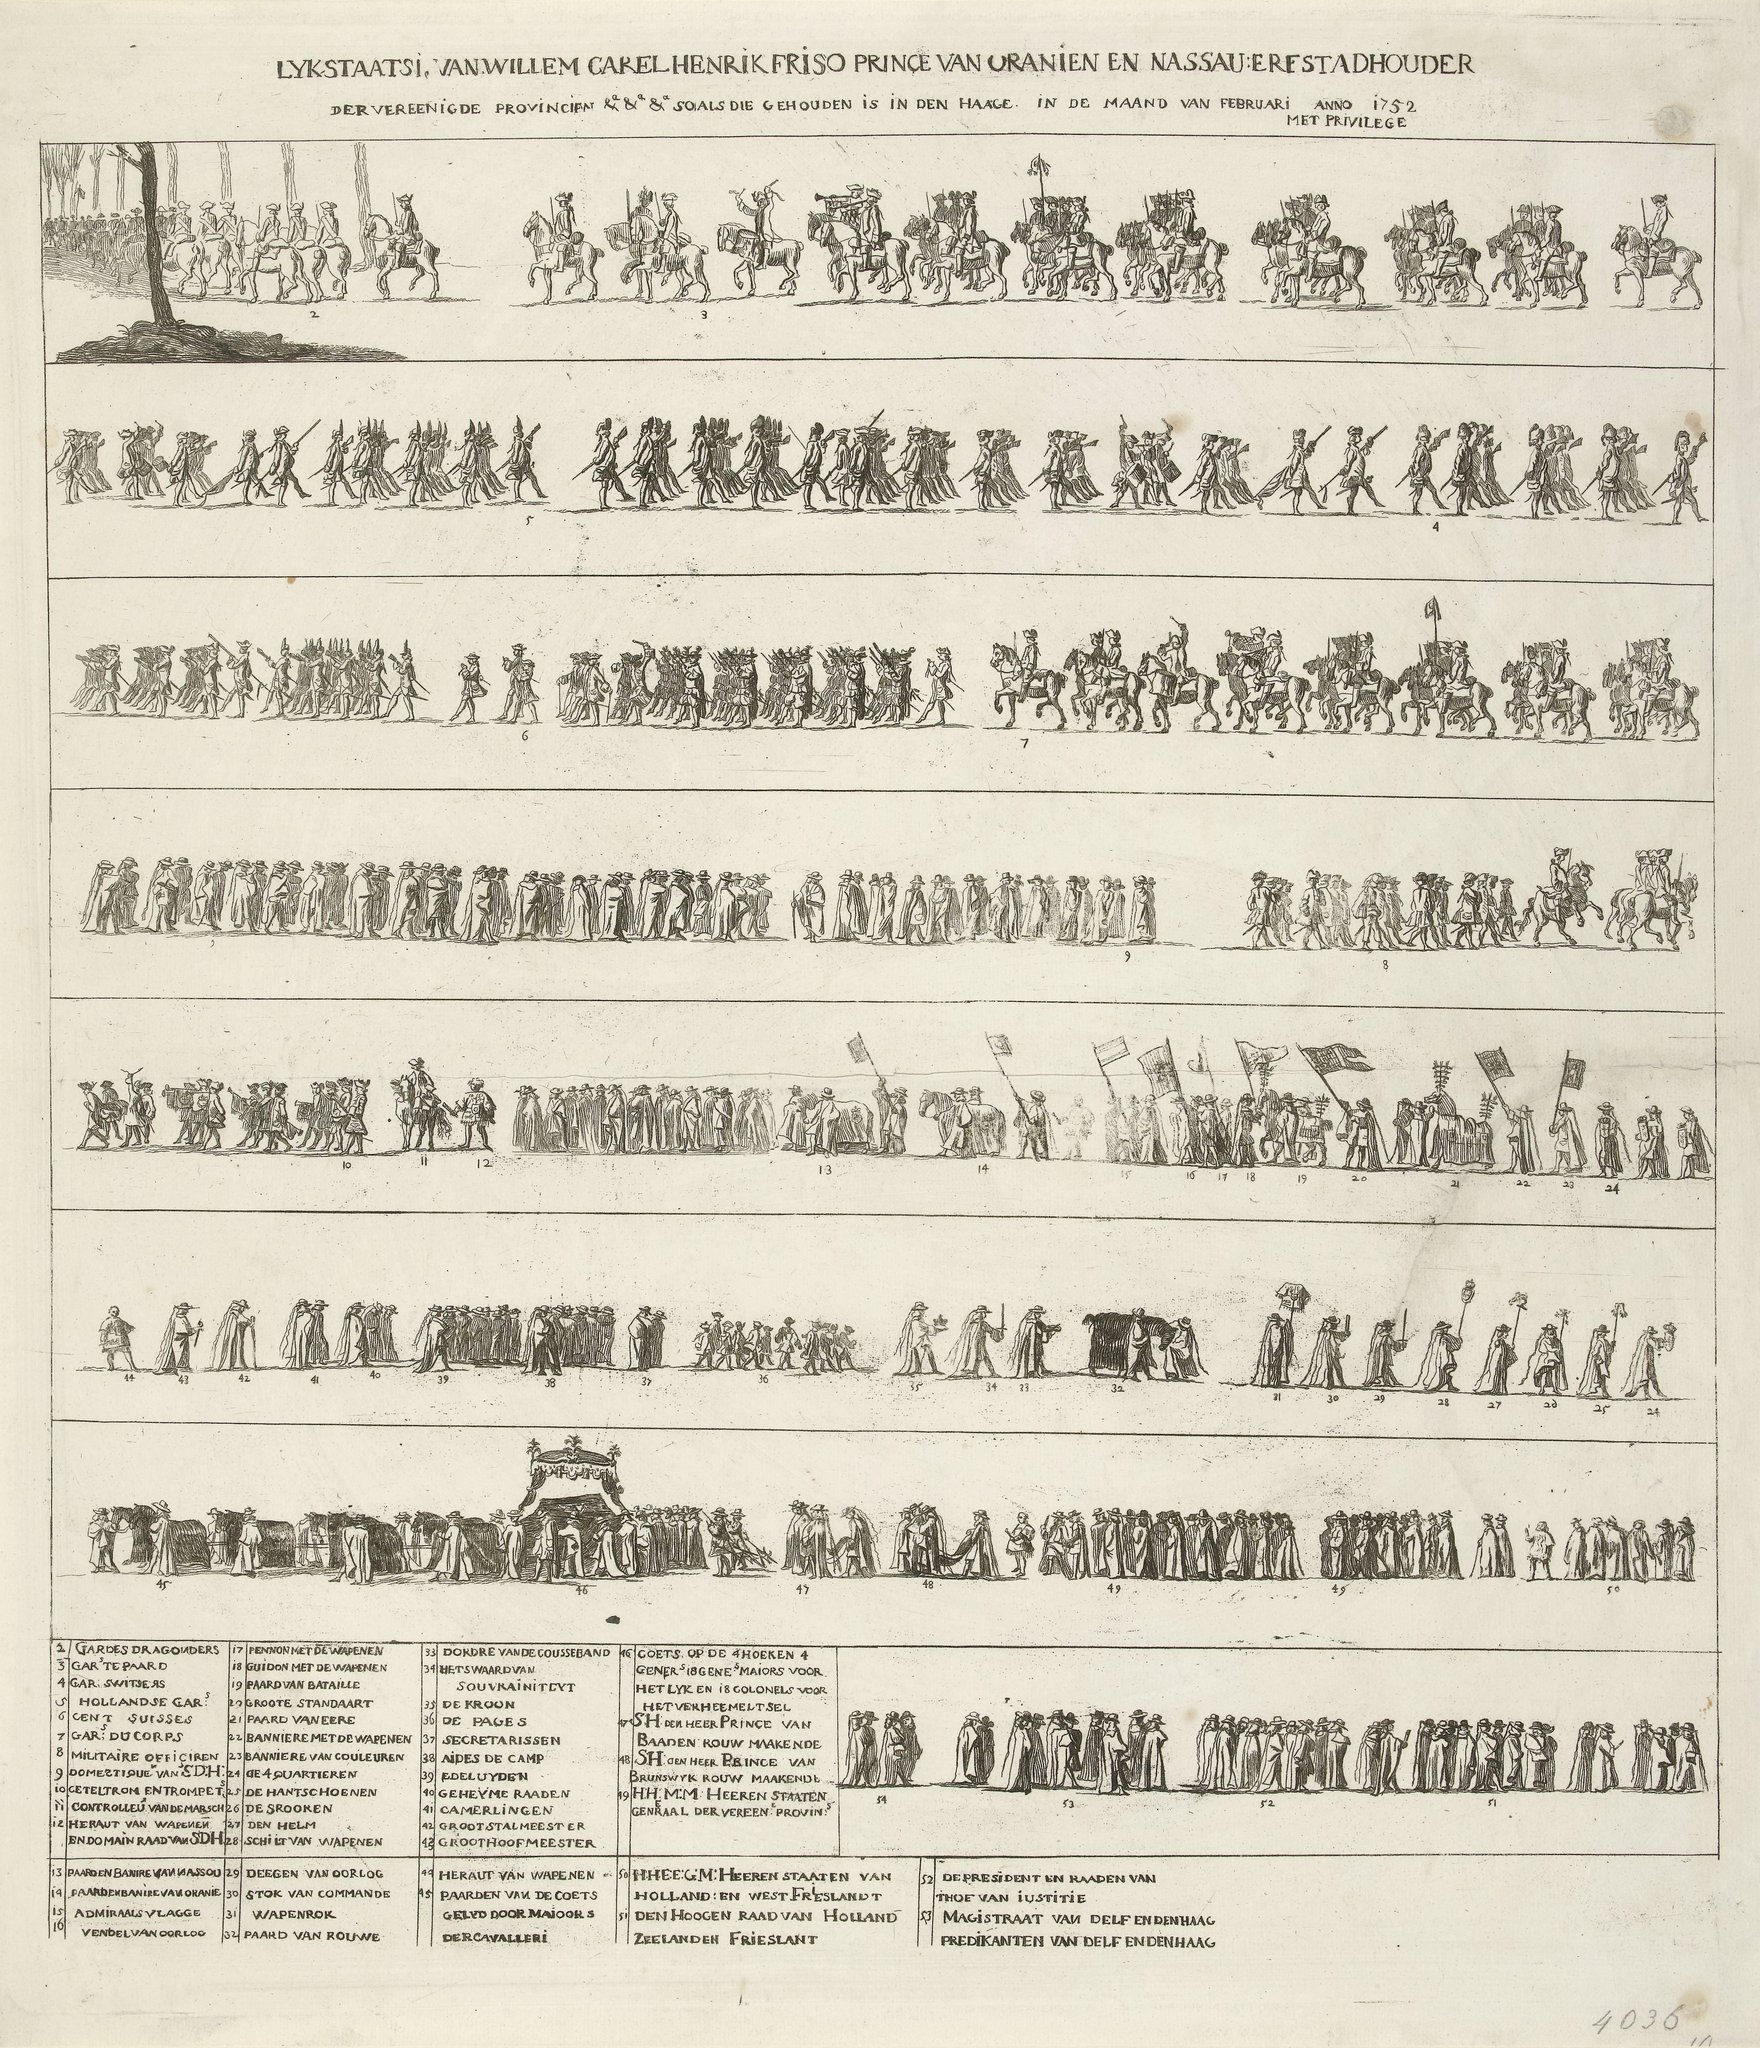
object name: print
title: Lykstaati van Willem Carel Henrik Friso Prince van Oranien en Nassau (...) soals die gehouden is in Den Haage in de maand Februari anno 1752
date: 1752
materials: paper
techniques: etching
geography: northern netherlands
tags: willem iv (prins van oranje-nassau), cortege, funeral procession, delft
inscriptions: collector's mark: Lugt 2228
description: De begrafenisstoet van stadhouder Willem IV op 4 februari 1752 te Delft. Processie afgebeeld in acht aparte rijen onder elkaar. Linksonderaan in de plaat de legenda 1-53.